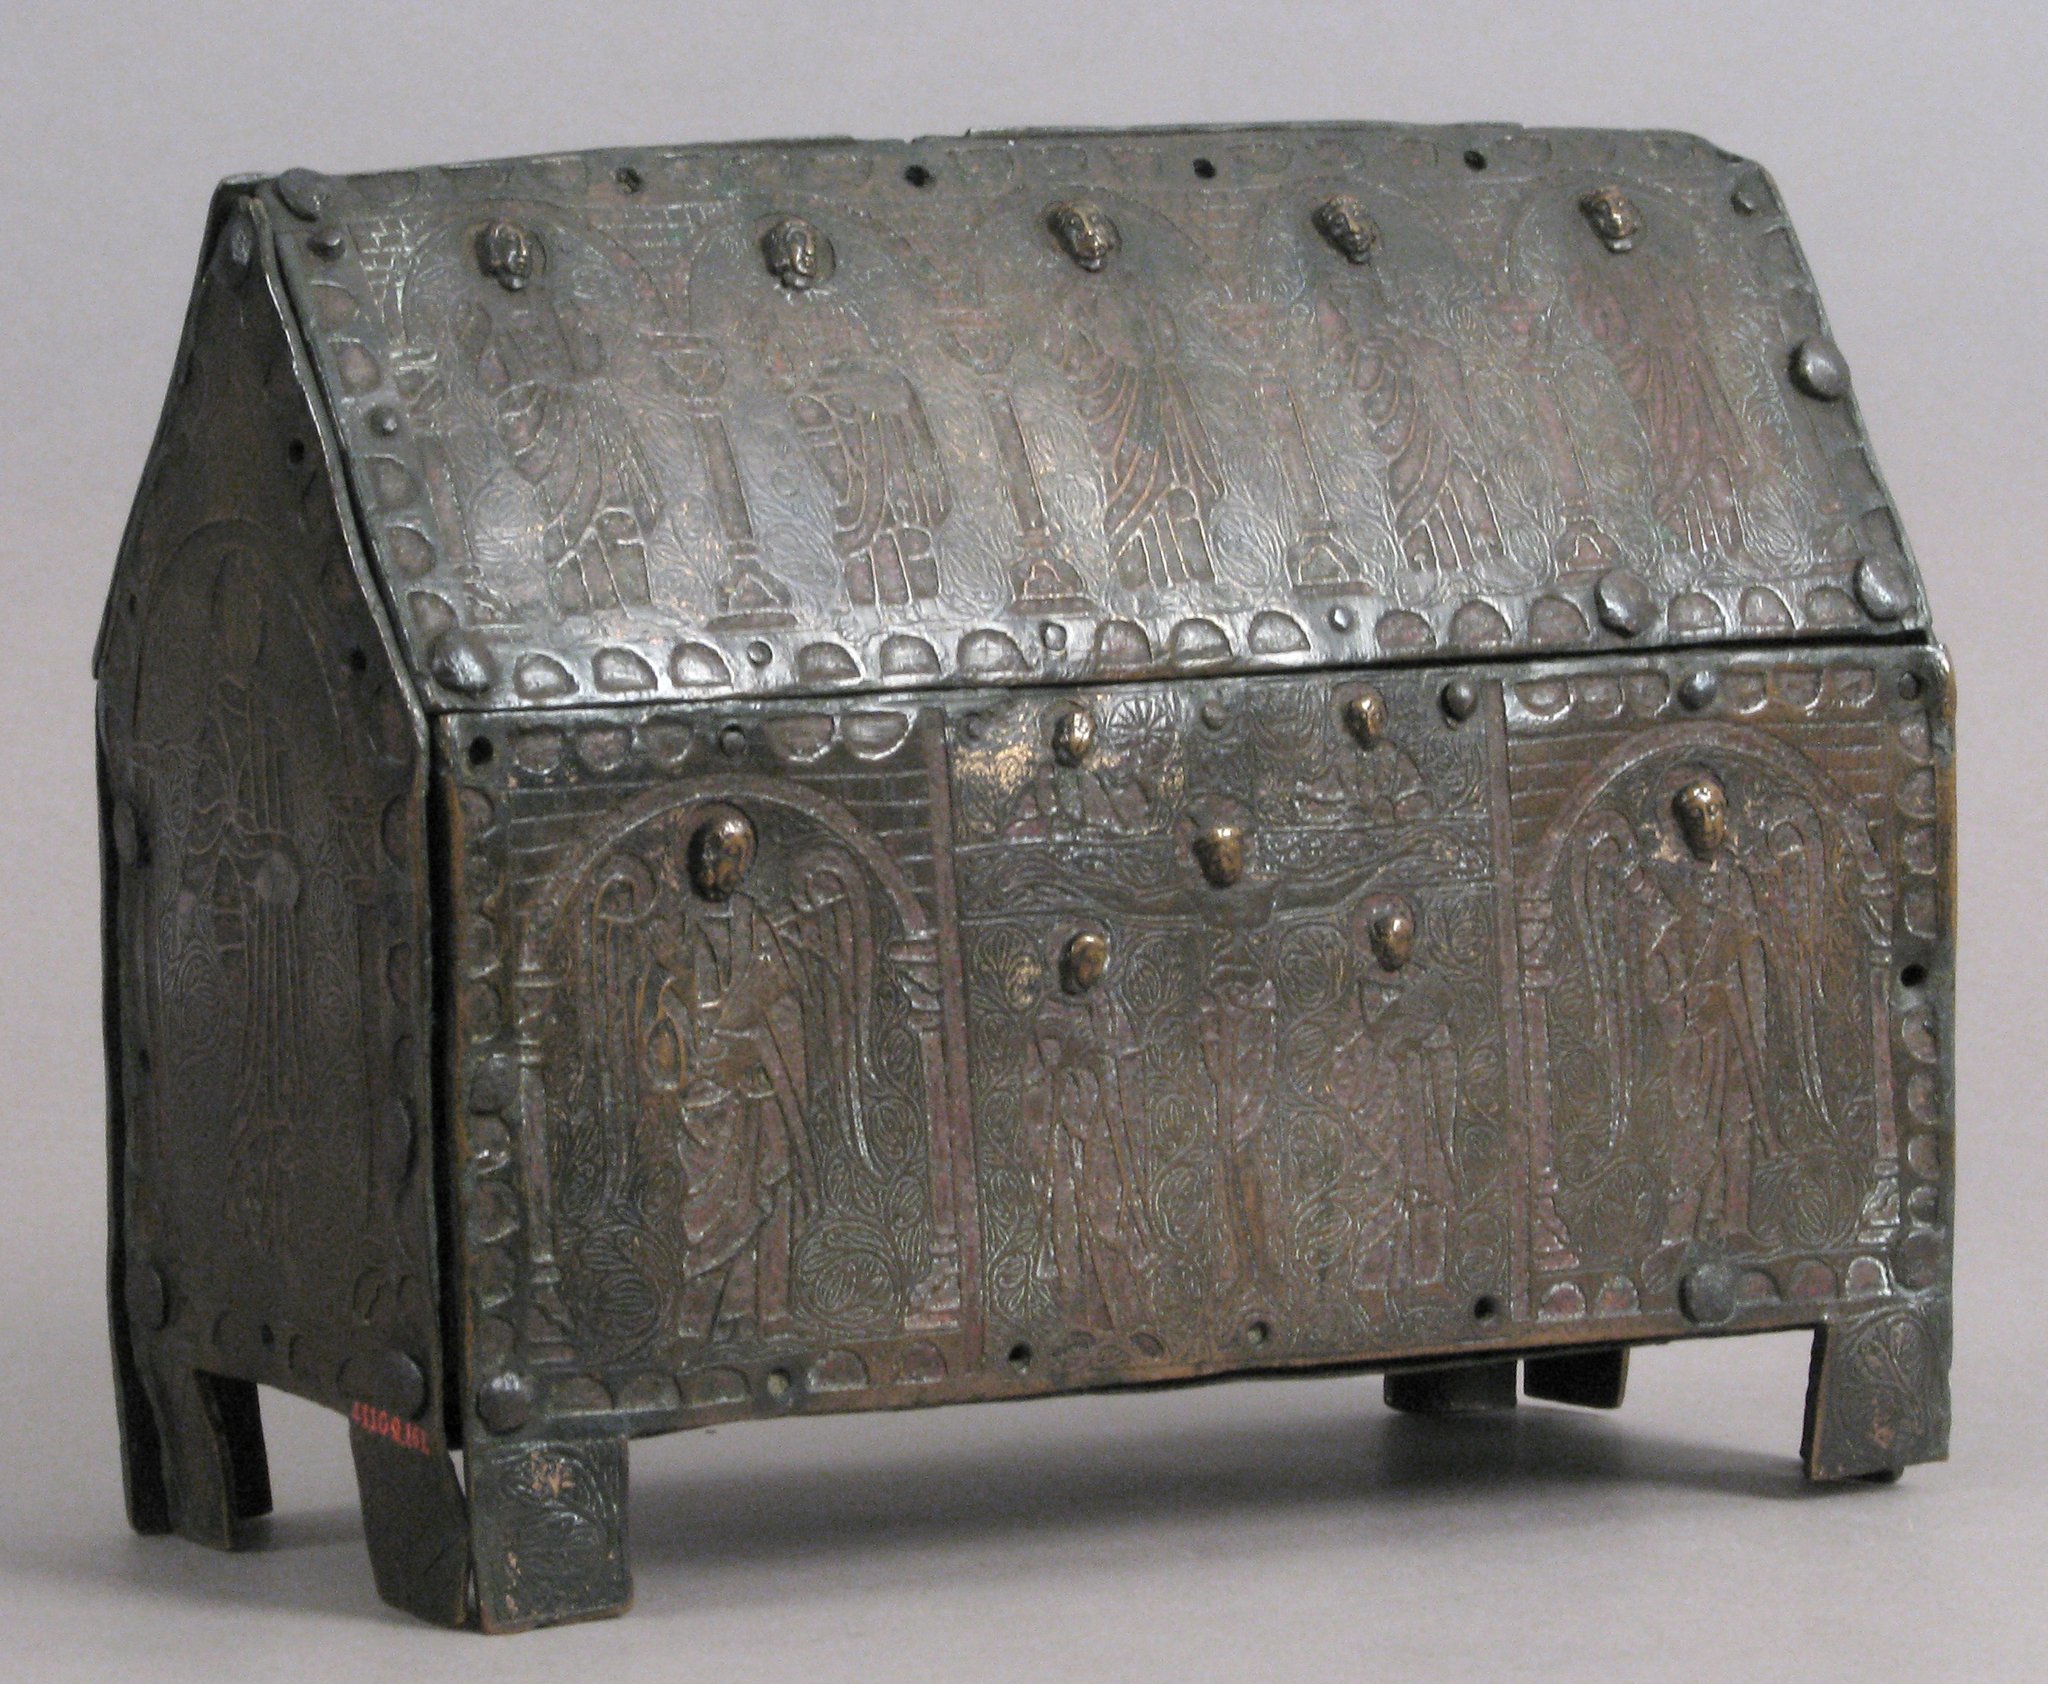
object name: chasse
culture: french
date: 1167-1233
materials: copper, enamel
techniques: enamel, gilding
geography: france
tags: angels,jesus